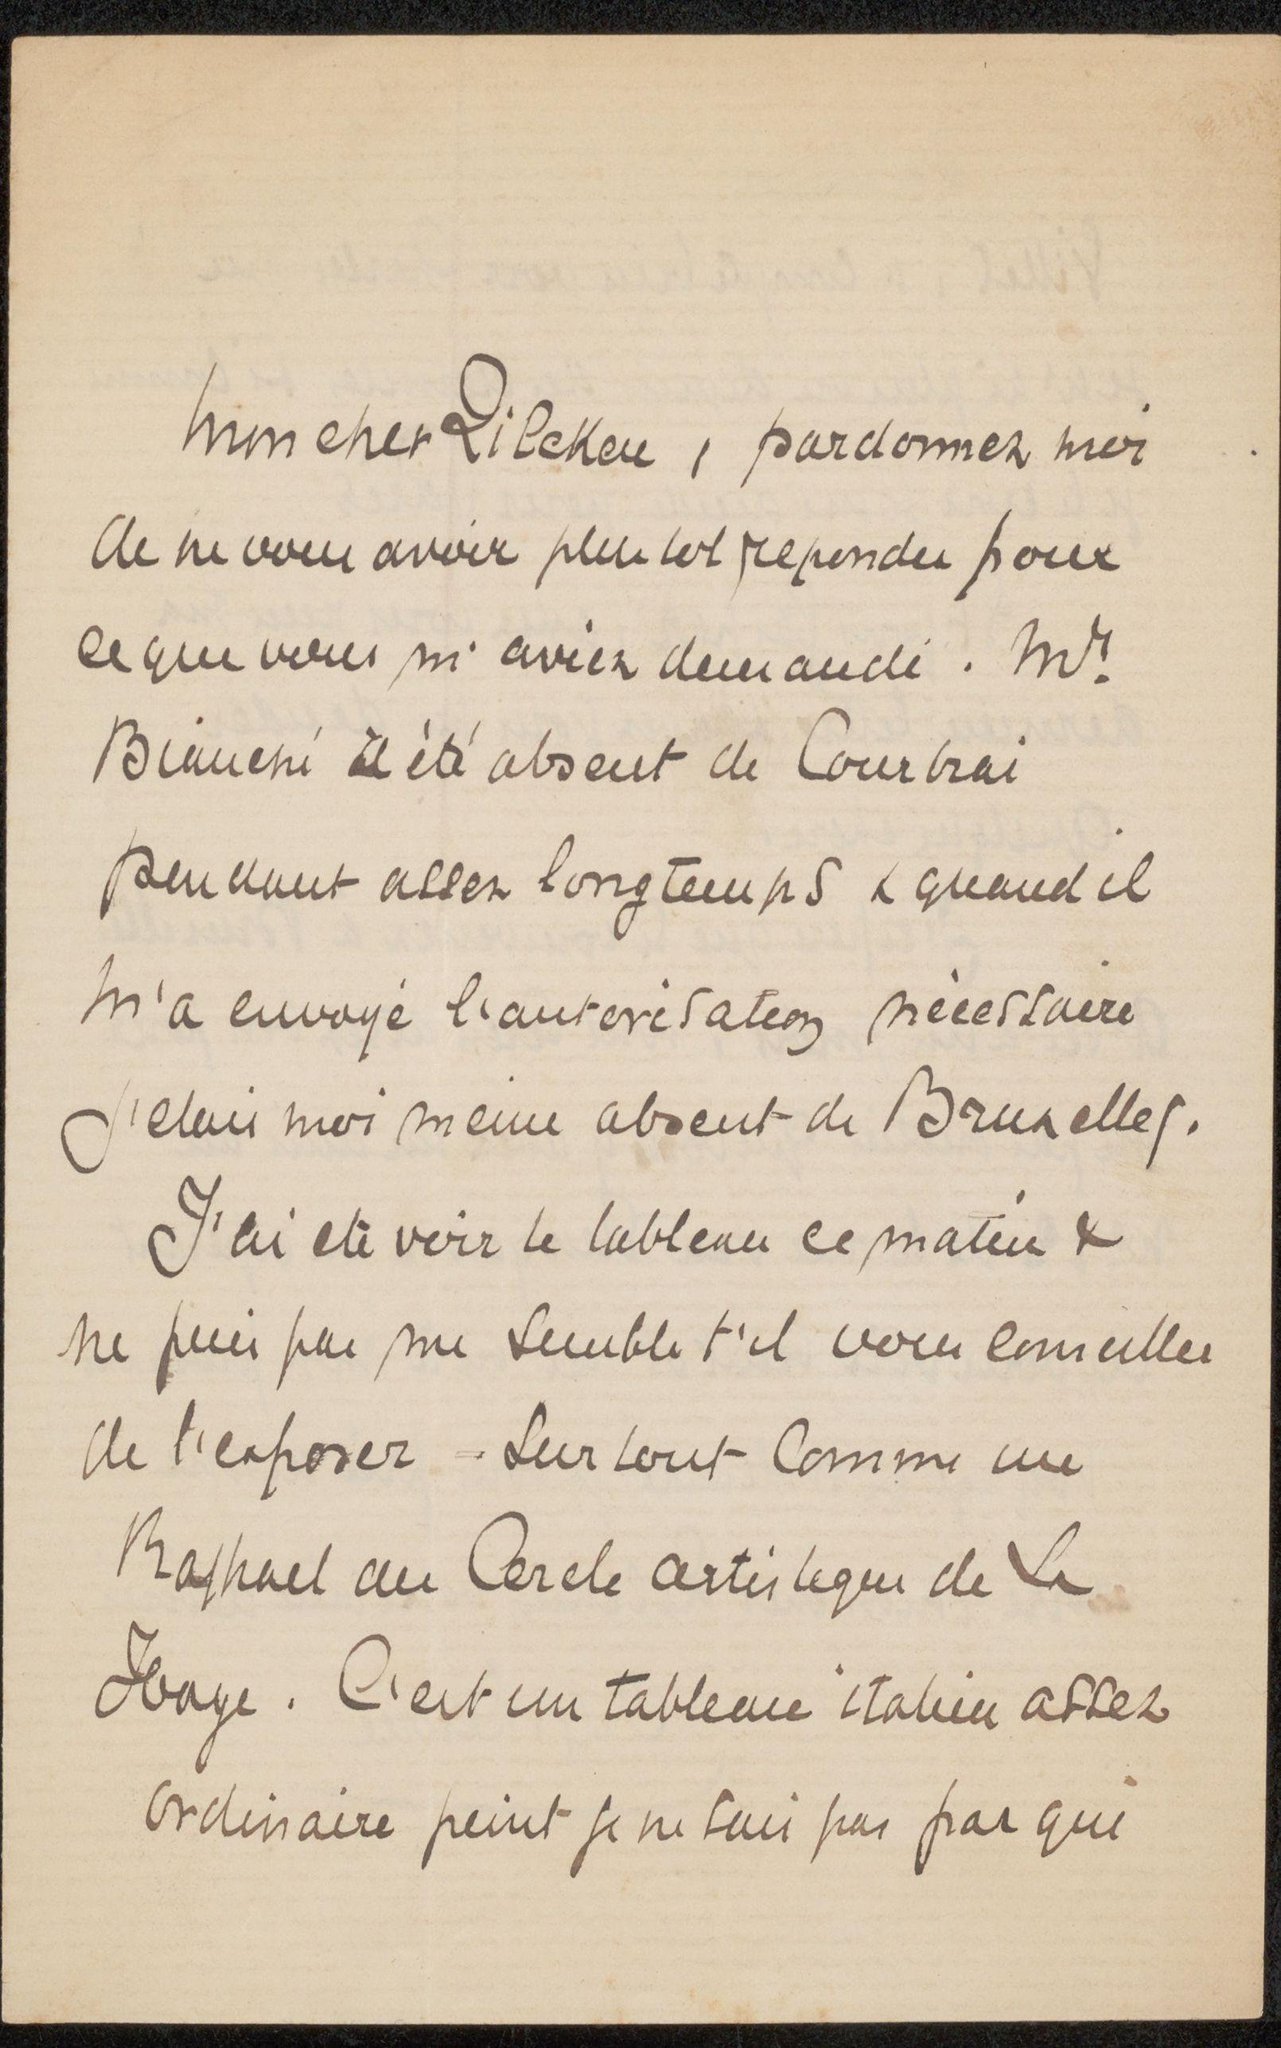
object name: letter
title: Brief aan Philip Zilcken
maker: olivier georges destrée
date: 1867-1904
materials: ink, paper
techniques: pen, writing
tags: print maker, mosè di giosuè bianchi, the hague, painter, draughtsman, philip zilcken, painting (including book-illumination, miniature-painting), exhibition ~ art, brussels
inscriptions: collector's mark: ‘RPK’